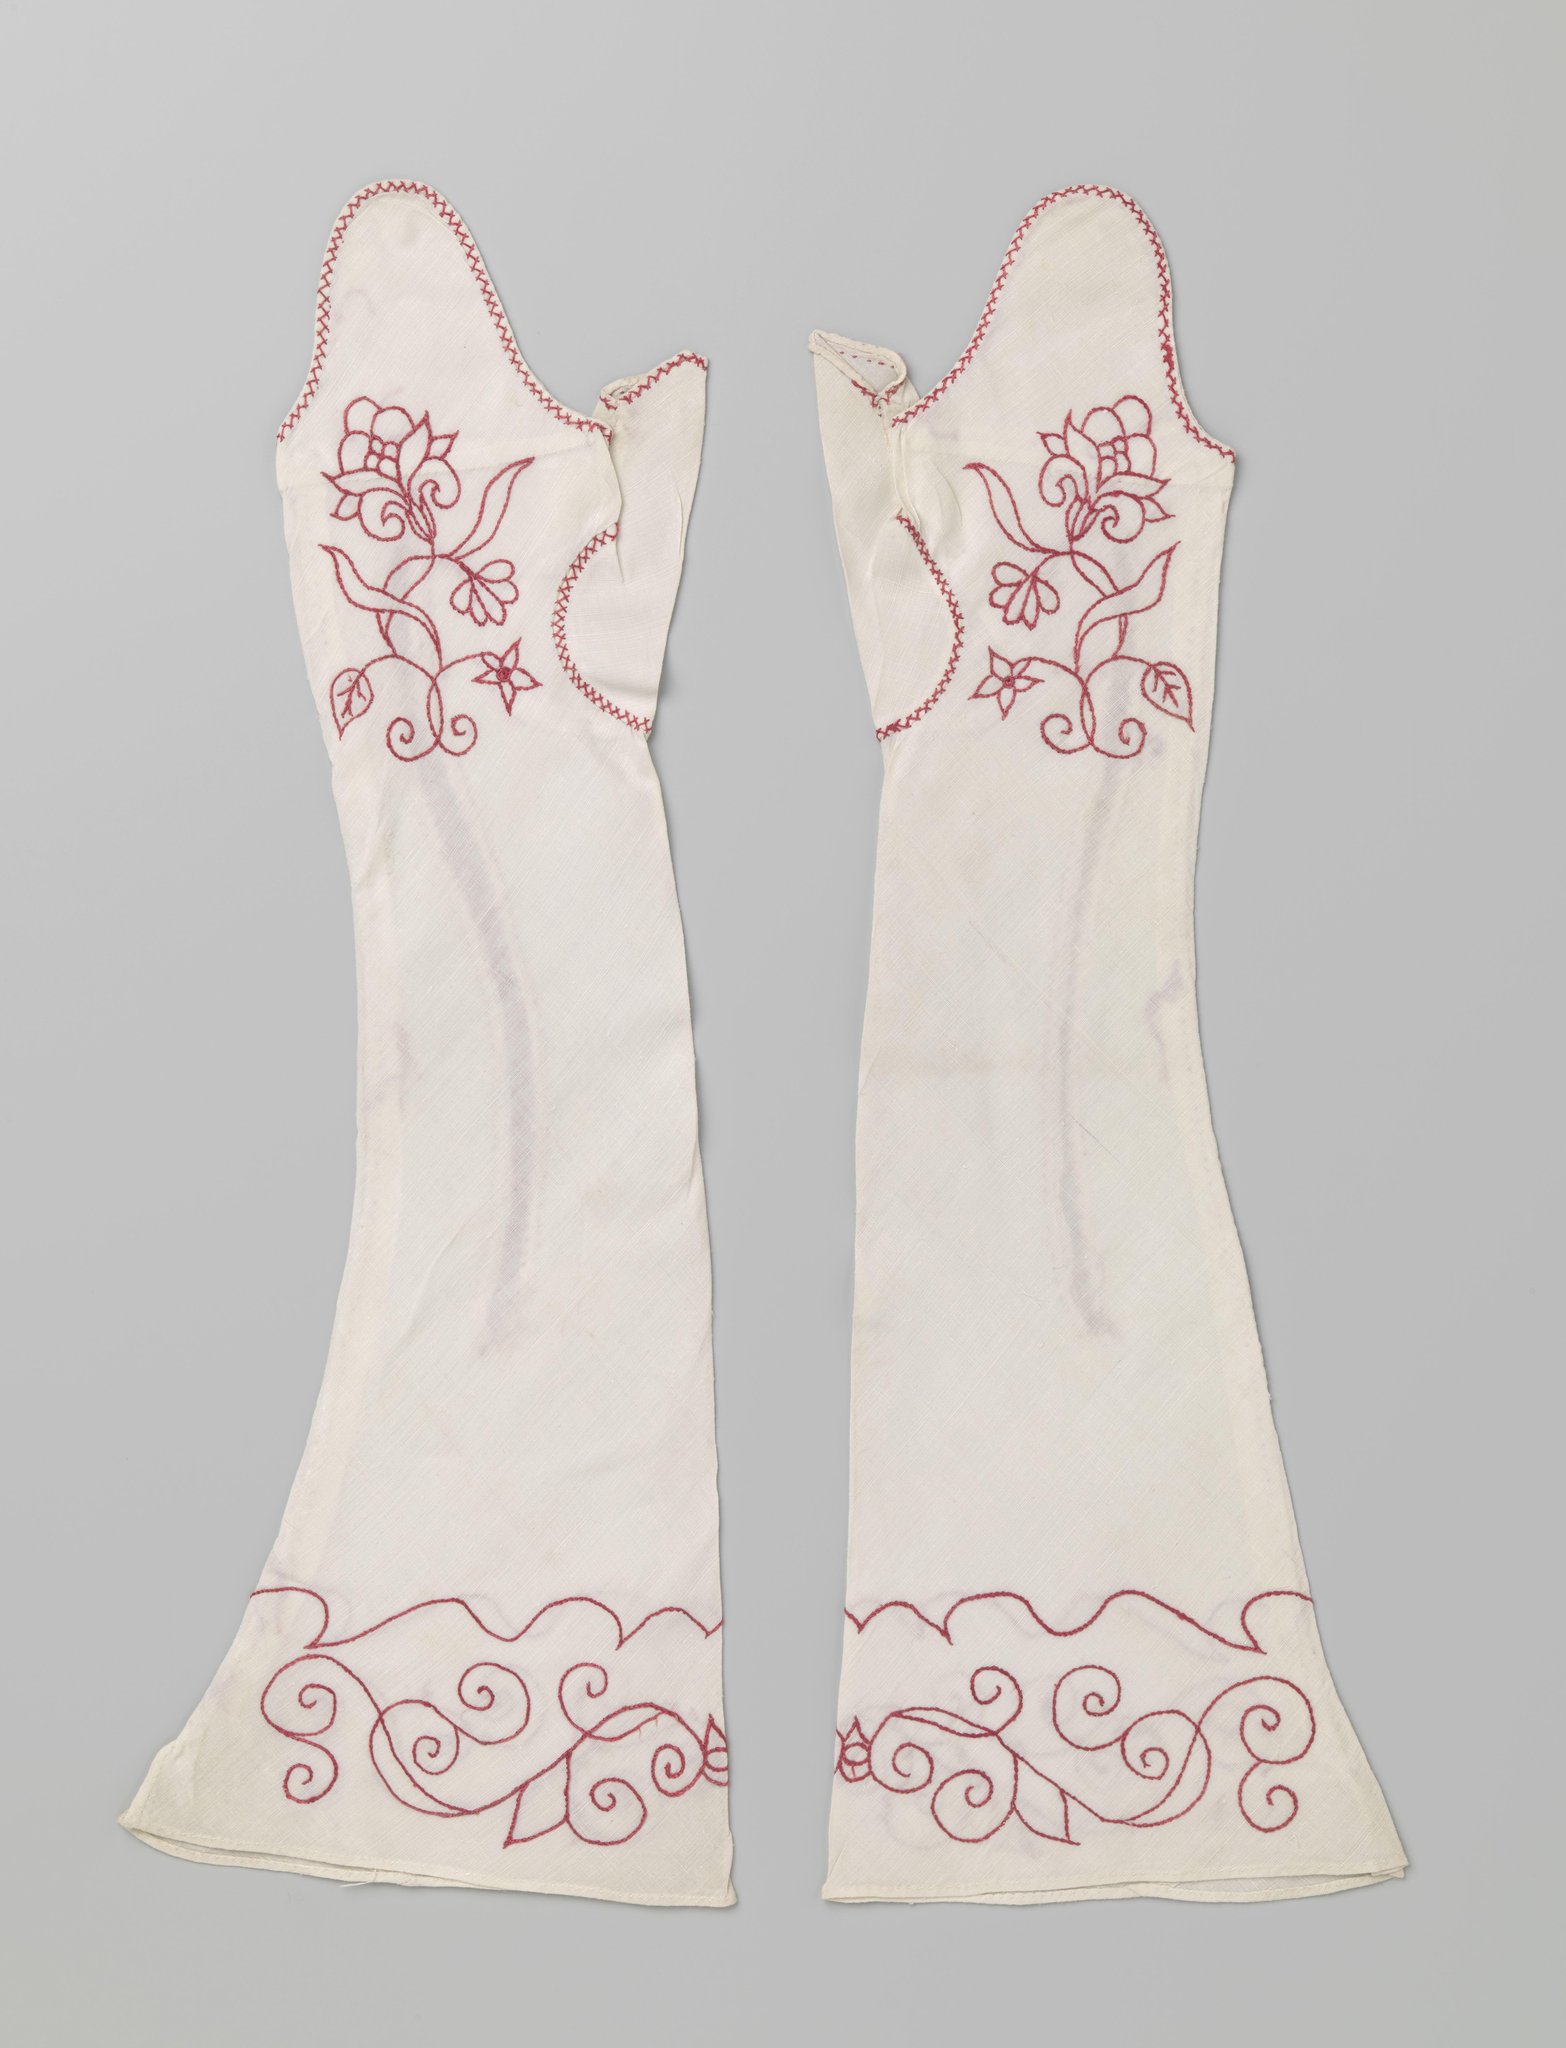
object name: clothing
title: Mitaine van wit linnen, in rood geborduurd met bloemtakken en takken met serpentine-voluten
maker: Anonymous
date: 1770-1780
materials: linen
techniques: embroidered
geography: netherlands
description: Mitaines van linnen, met gelijk patroon geborduurd, het éne in rood, het andere in lichtblauw, ROKOKO-DECOR. Model: Ellebooglang en van schuine stof geknipt voor de rekbaarheid. Afzonderlijke, ingezette duimen. Een handrugpunt is met linnen plaatselijk gevoerd. Gerekte S-vormige splitten zijn met rekbare flanelsteken dichtgemaakt. Borduurpatroon: Op de handruggen zijn - links symmetrisch t.o.v. rechts - bloemtakken in steelsteek gewerkt, doch alleen in dubbele contouren, bovenaan staan fijne slingerende takken met serpentine-voulten. zij zijn symmetrisch verdubbeld en door een slinger liljn en gesloten. Alle naden zijn geaccentueerd; de rode mitaines met flanelsteken, de blauwe met golfijn in steelsteek. Toestand: gewassen, in 1979. Was wel riskant, maar het kunnen was te vuil, waardoor de vezels zouden gaan slijten. Bij het wassen is van één exemplaar van no. b. de blauwe zijde in het split half kapot gegaan.